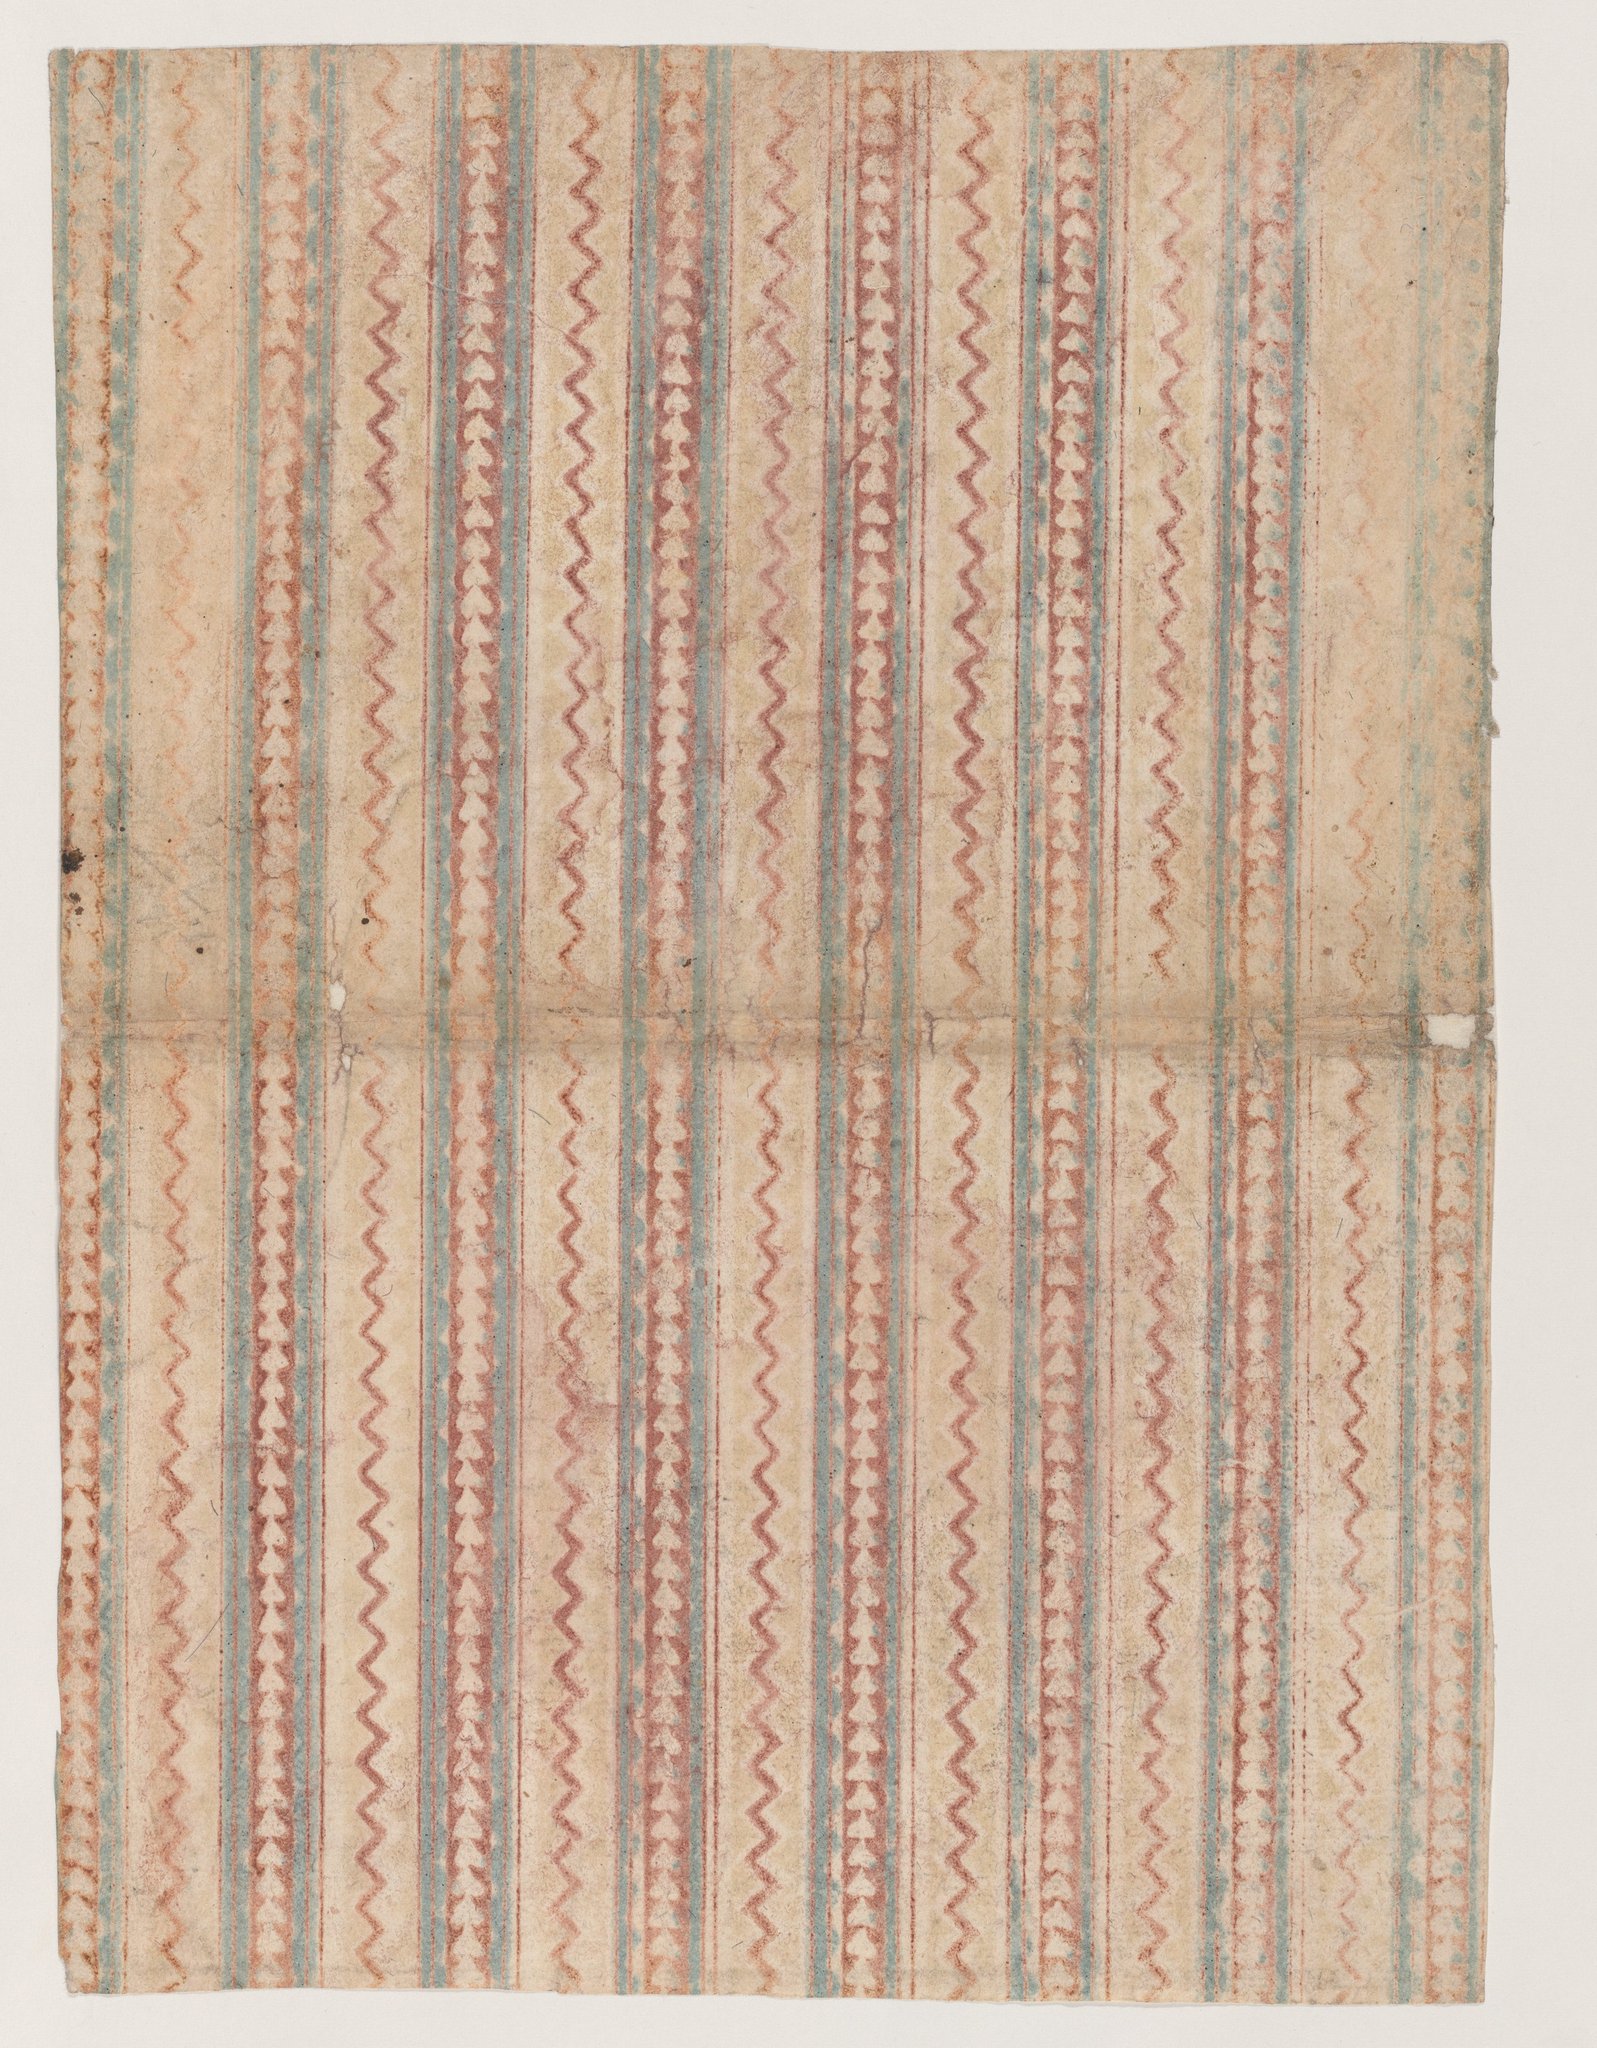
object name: print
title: Book cover with overall stripe, zigzag, and triangle pattern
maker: Anonymous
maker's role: artist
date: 1801-1900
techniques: relief print